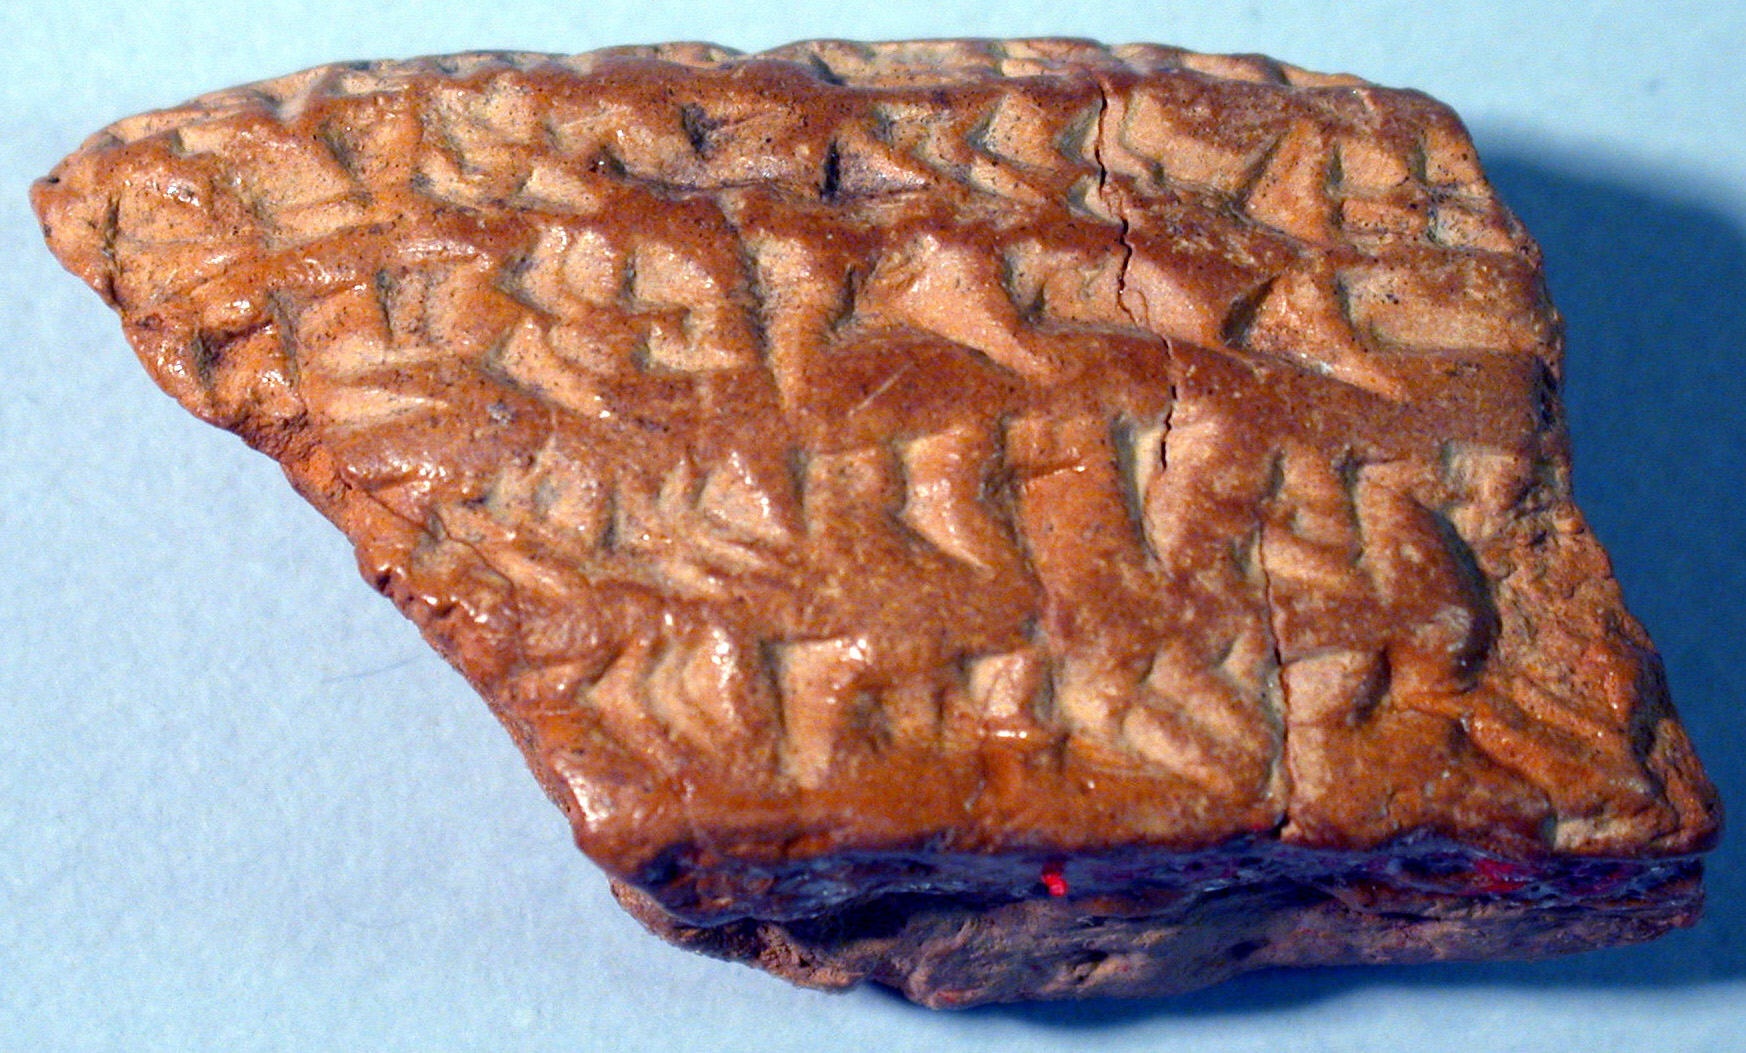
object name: cuneiform tablet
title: Cuneiform tablet: fragment of a contract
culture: babylonian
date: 626-539 BCE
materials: clay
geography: mesopotamia